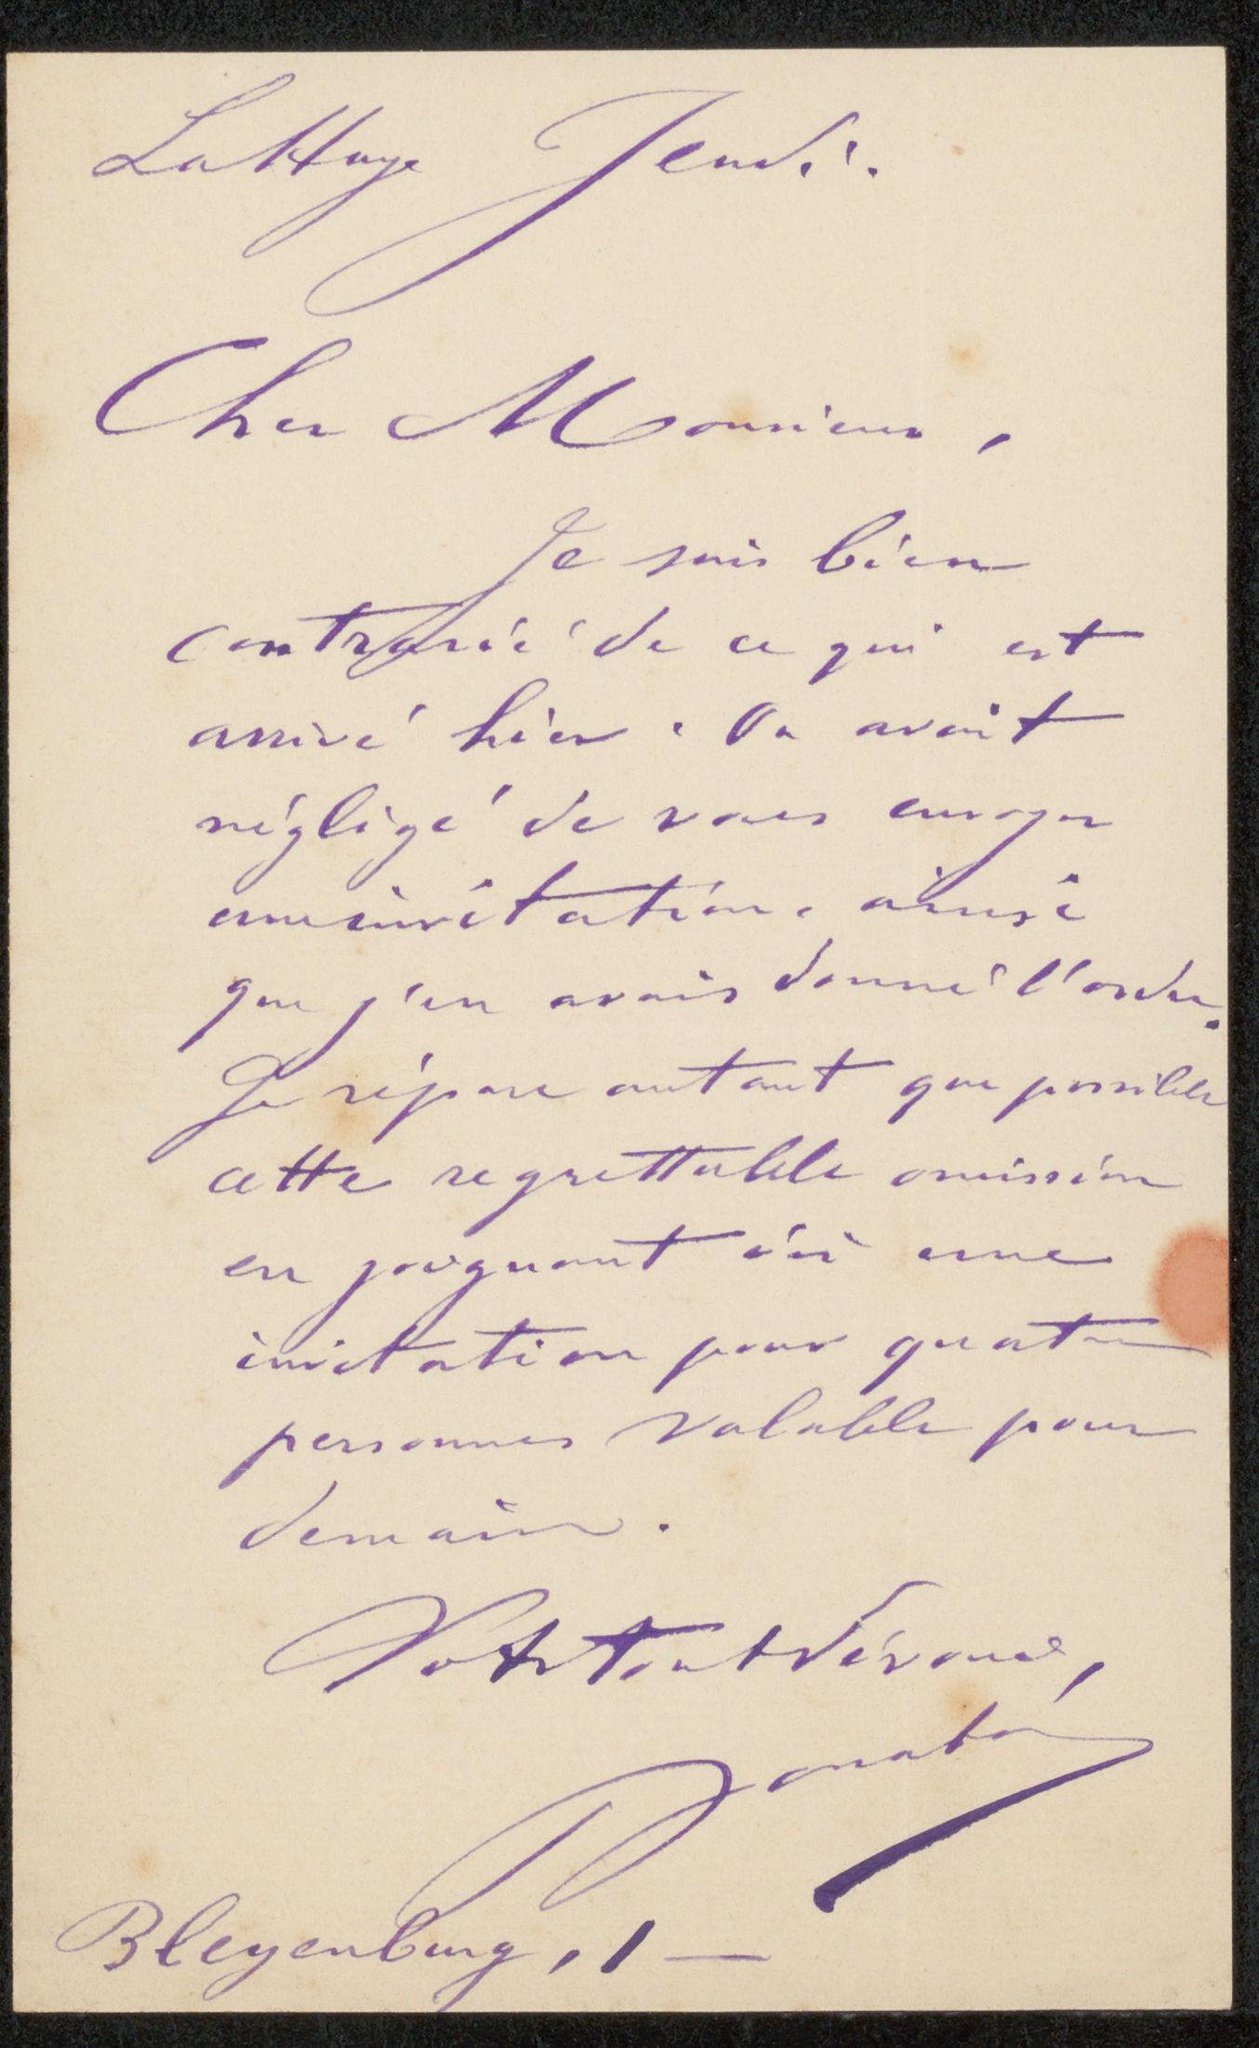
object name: letter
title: Brief aan Philip Zilcken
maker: donato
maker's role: schrijver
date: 1867-1930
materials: ink, paper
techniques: pen, writing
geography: the hague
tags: painter, draughtsman, philip zilcken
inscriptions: collector's mark: ‘RPK’